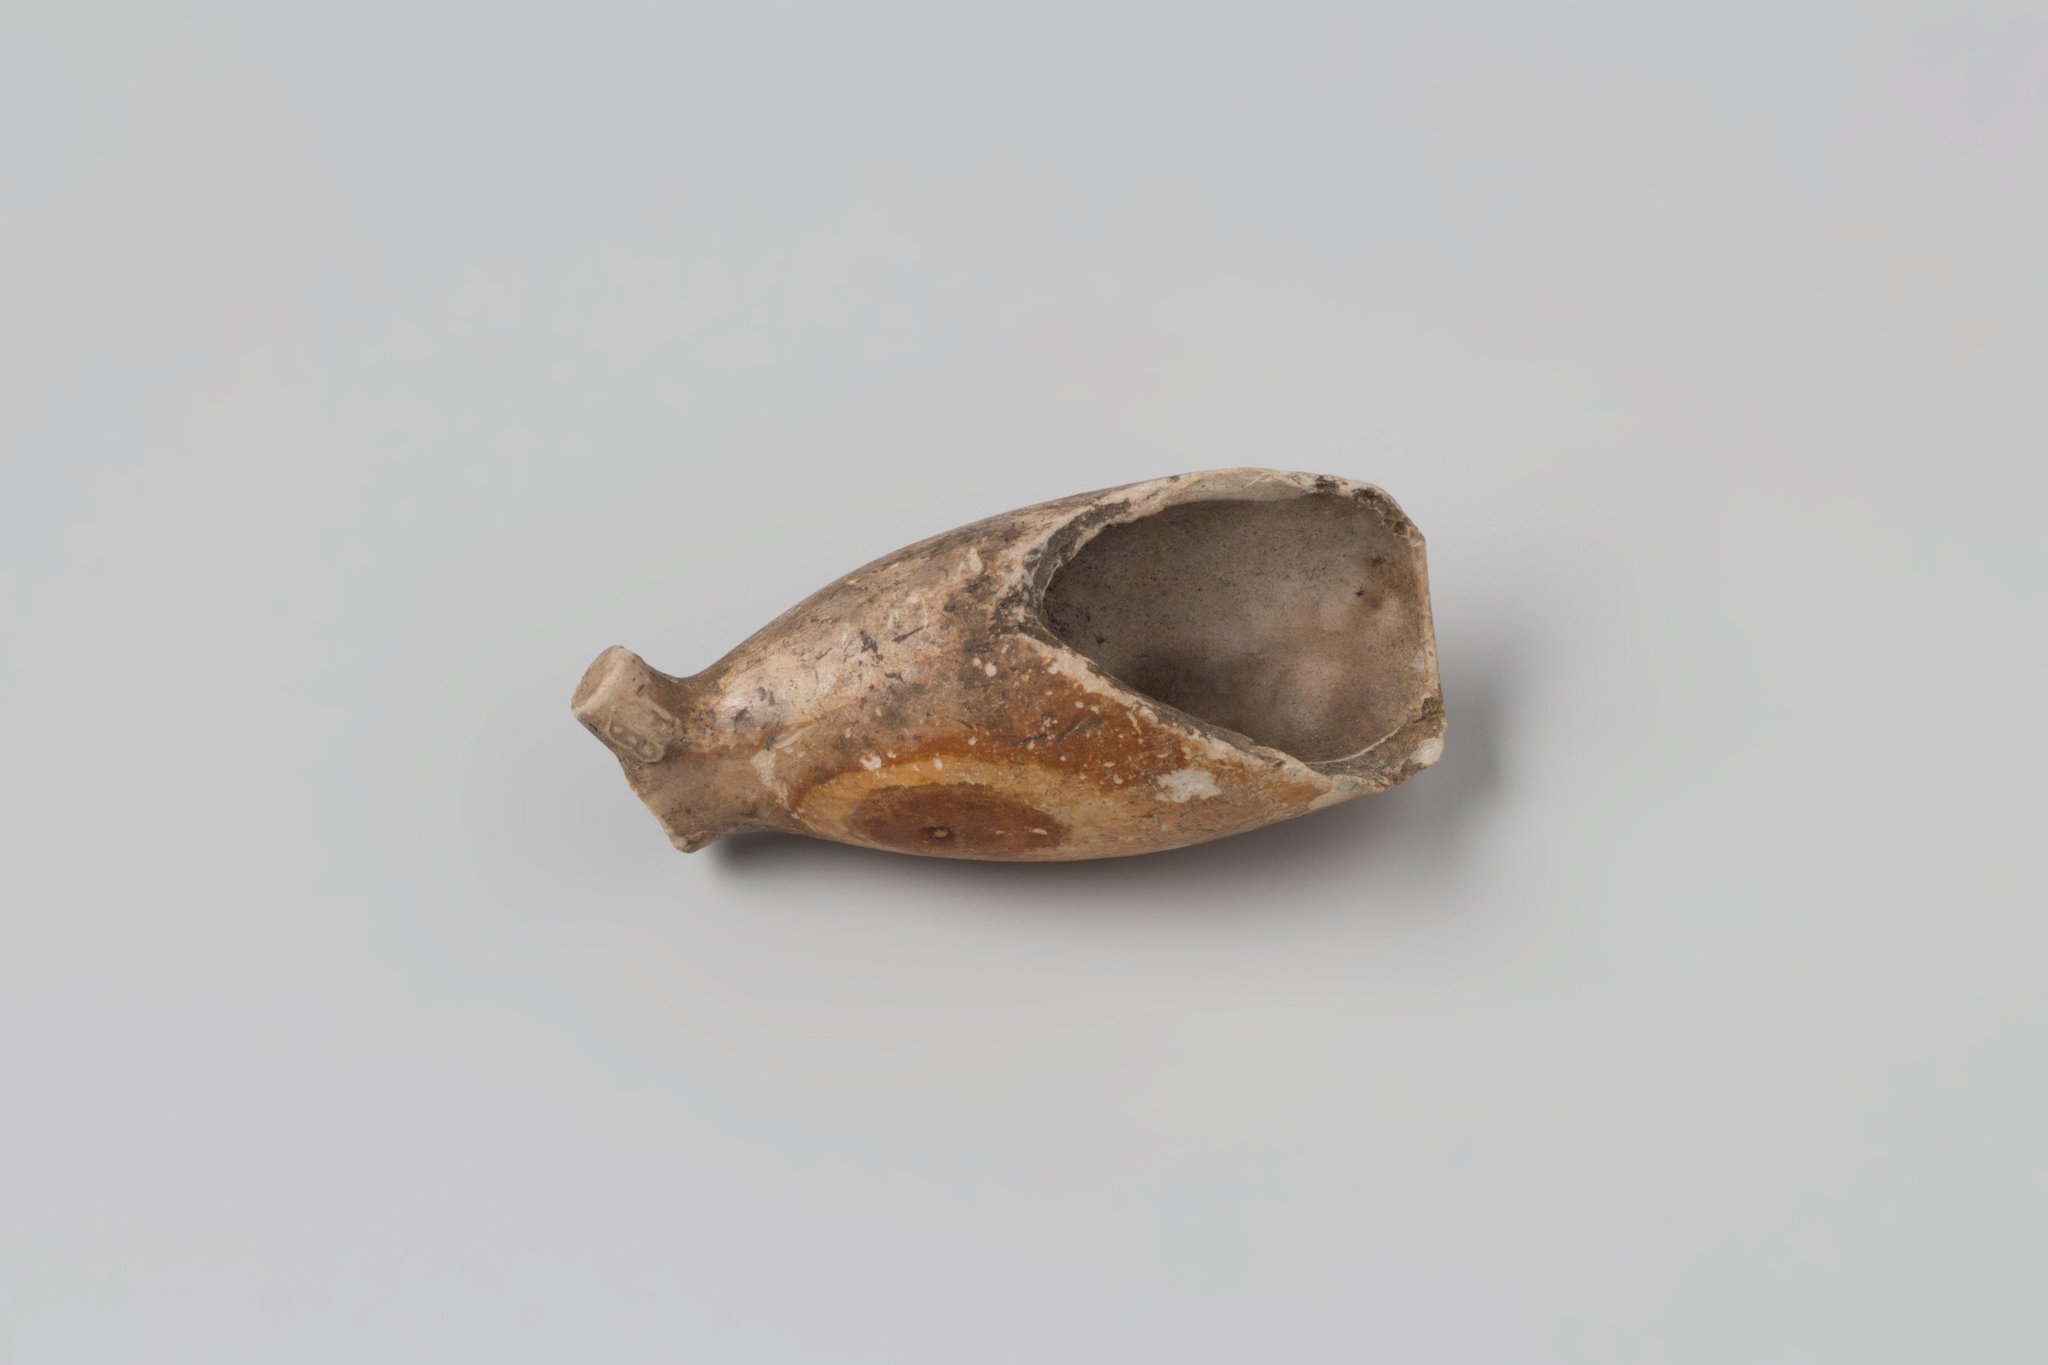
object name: pipe bowl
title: Fragment pijpenkop uit het wrak van de Oost-Indiëvaarder Hollandia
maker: Anonymous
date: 1700-1743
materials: clay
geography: netherlands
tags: verenigde oostindische compagnie, hollandia (schip), annet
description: Pipe, bowl, heelmark: dog; fragm, 1hsm1.